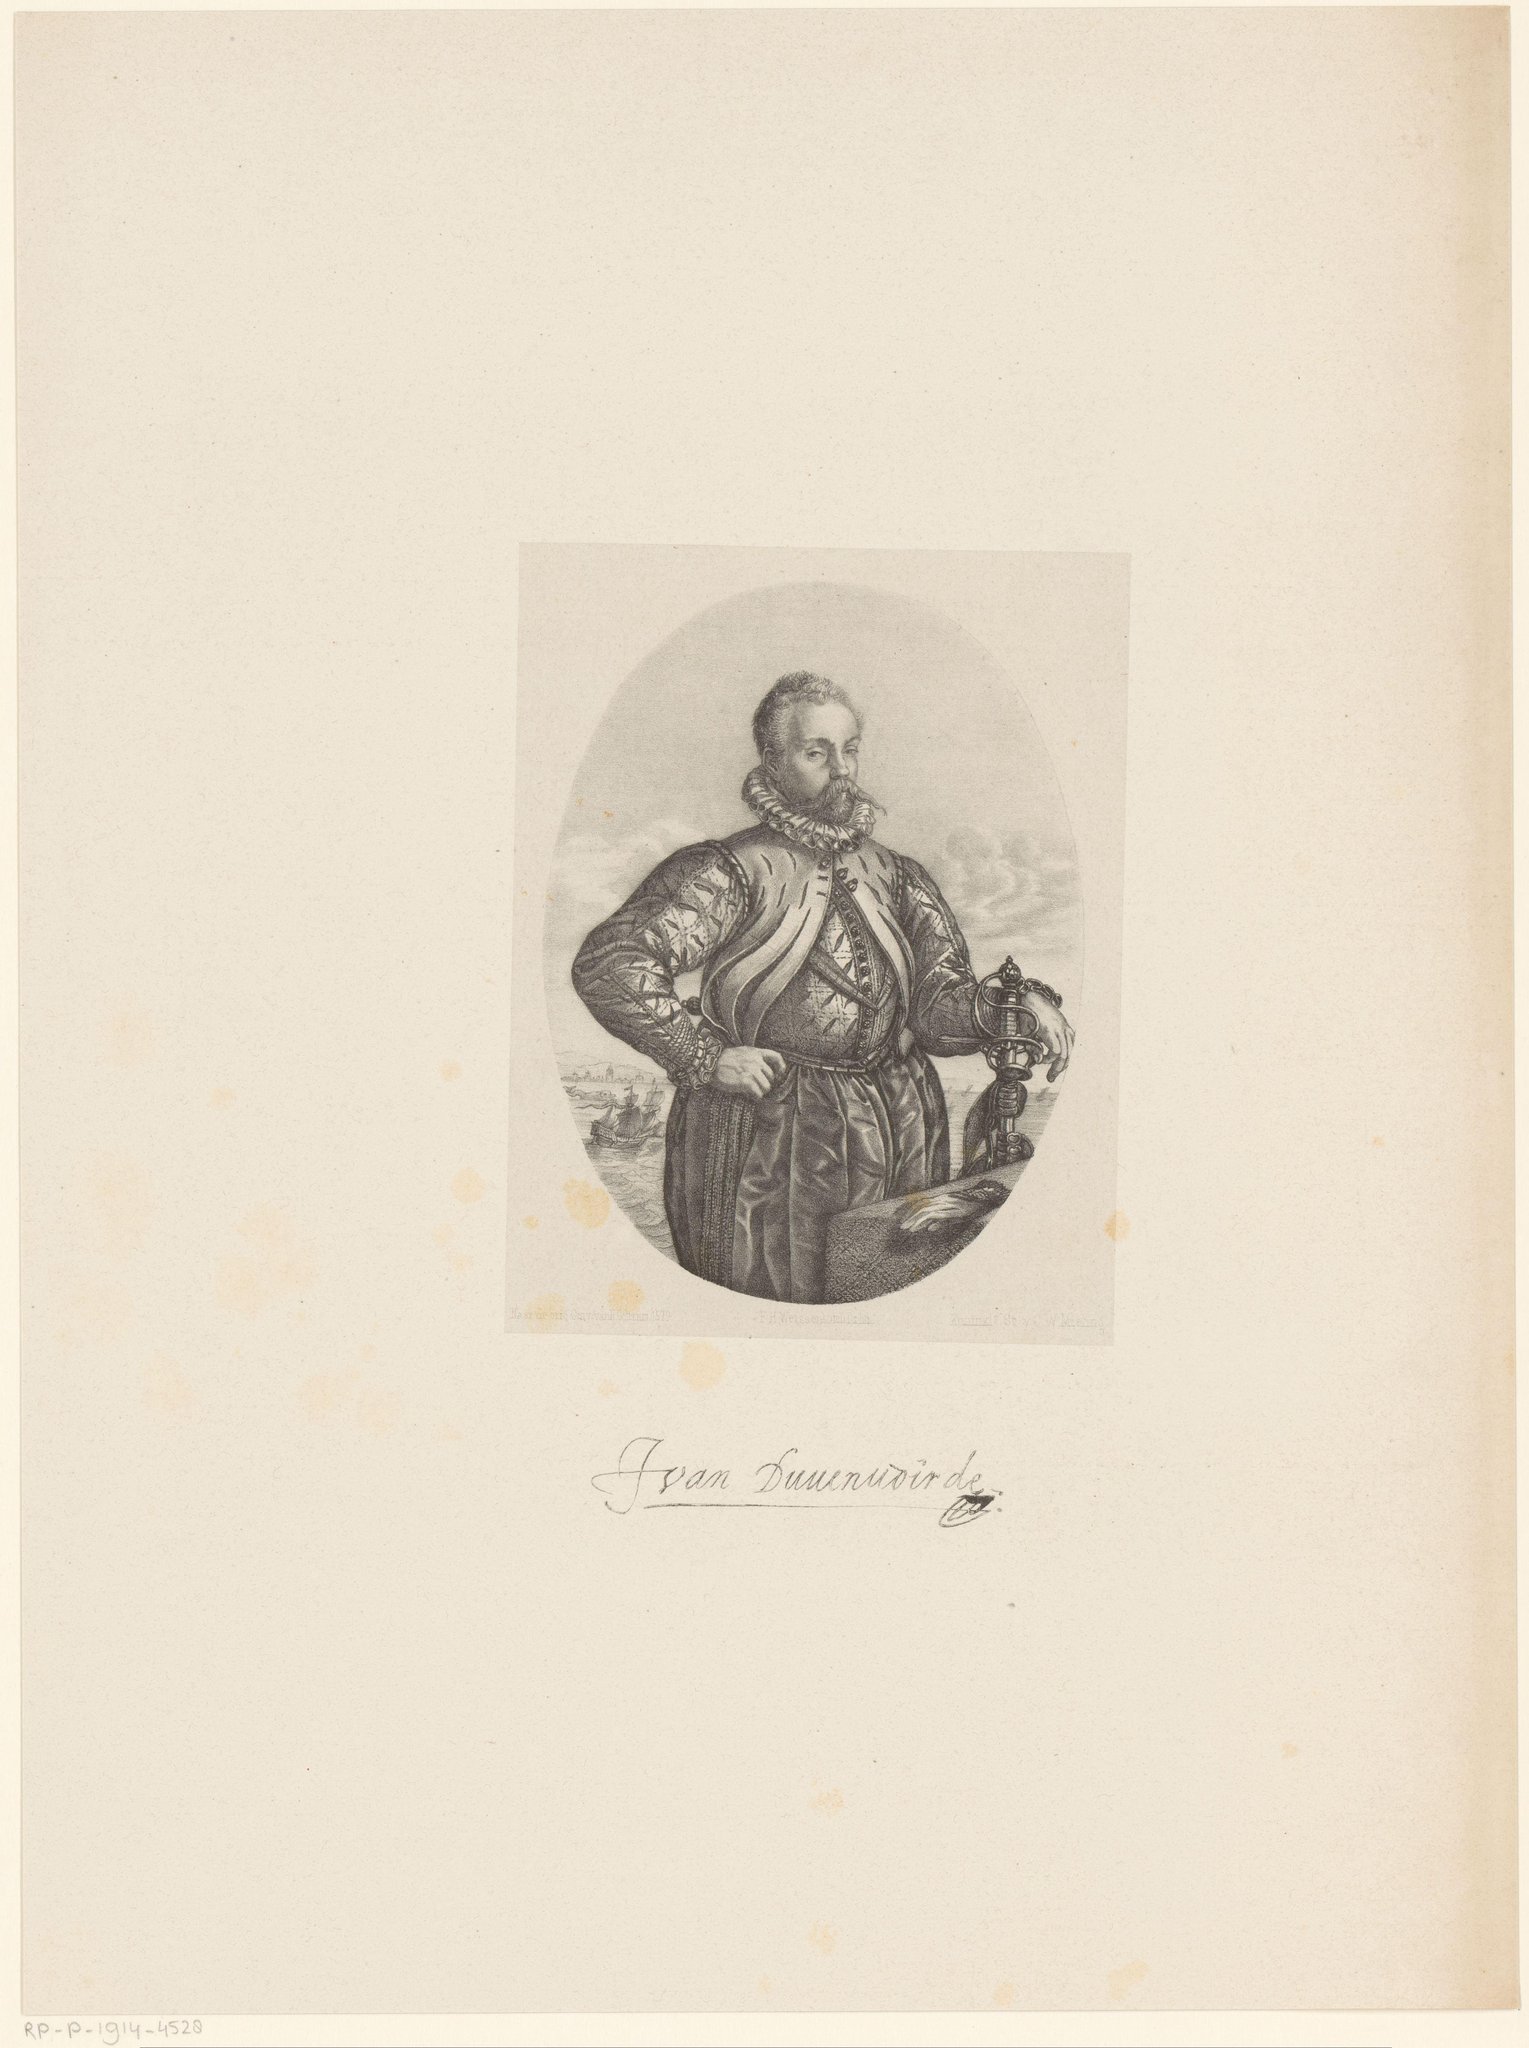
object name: book illustration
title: Portret van Johan van Duvenvoorde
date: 1858-1862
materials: paper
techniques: lithograph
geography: the hague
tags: the hague, historical persons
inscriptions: collector's mark: Lugt 2228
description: Zie RP-P-OB-10.142. Prent uit: Jonge, J.C. de. Geschiedenis van het Nederlandsche zeewezen. Haarlem: Jonge, J.K.J. de, 1858-62.